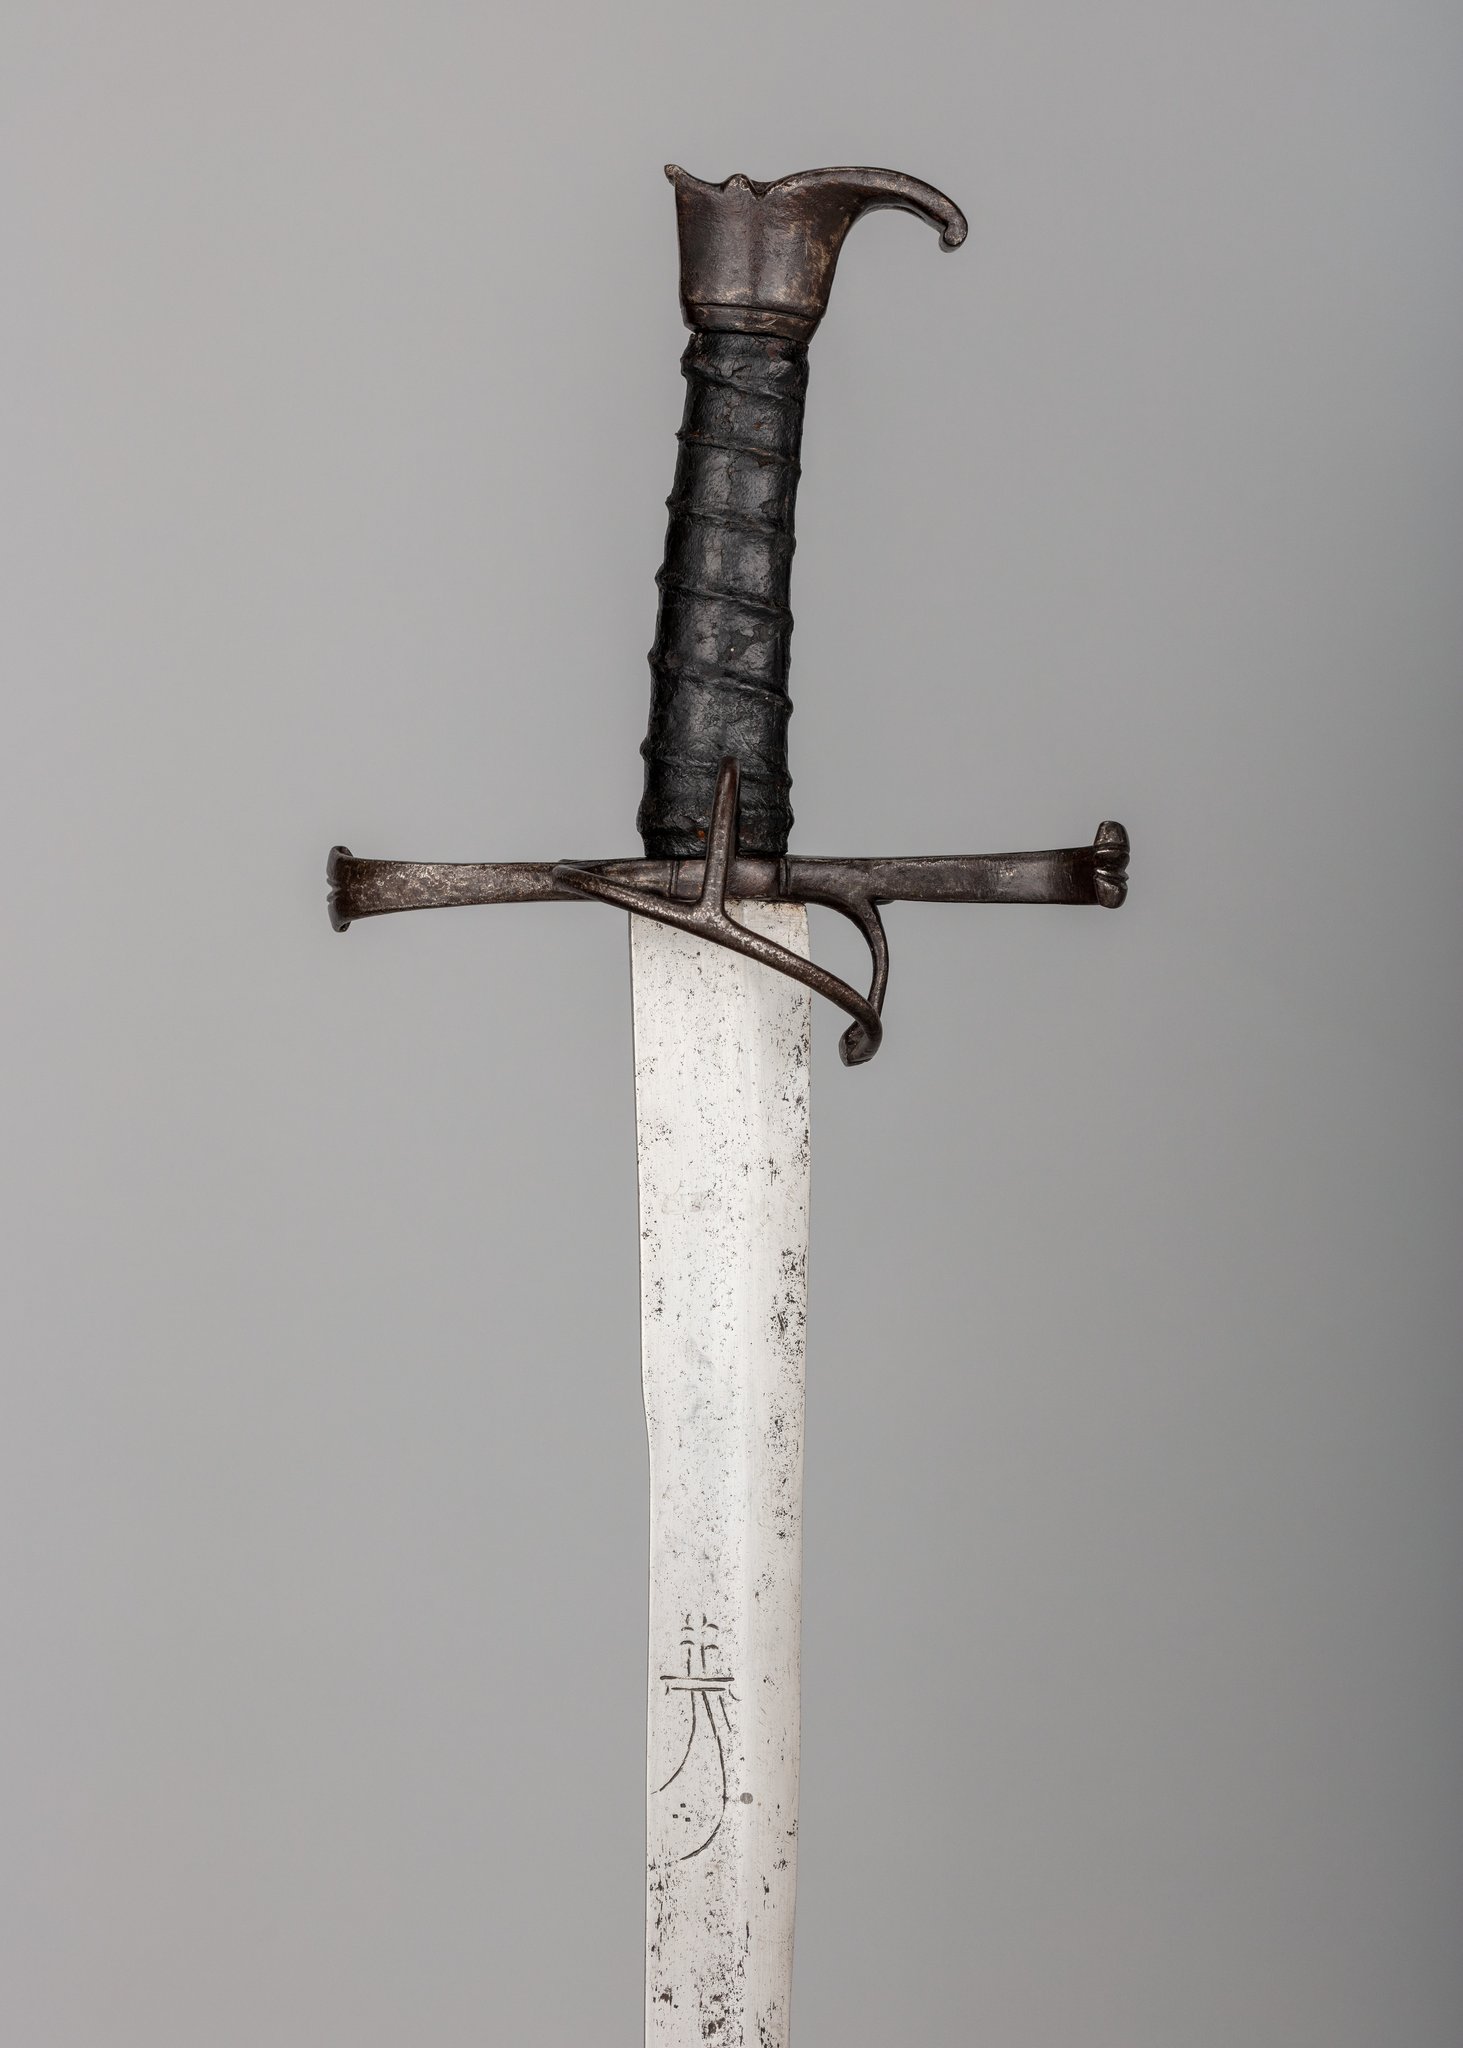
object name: swiss saber i schweizersäbel i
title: Swiss Saber (Schweizersäbel)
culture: swiss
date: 1501-1533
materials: leather, steel, wood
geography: switzerland